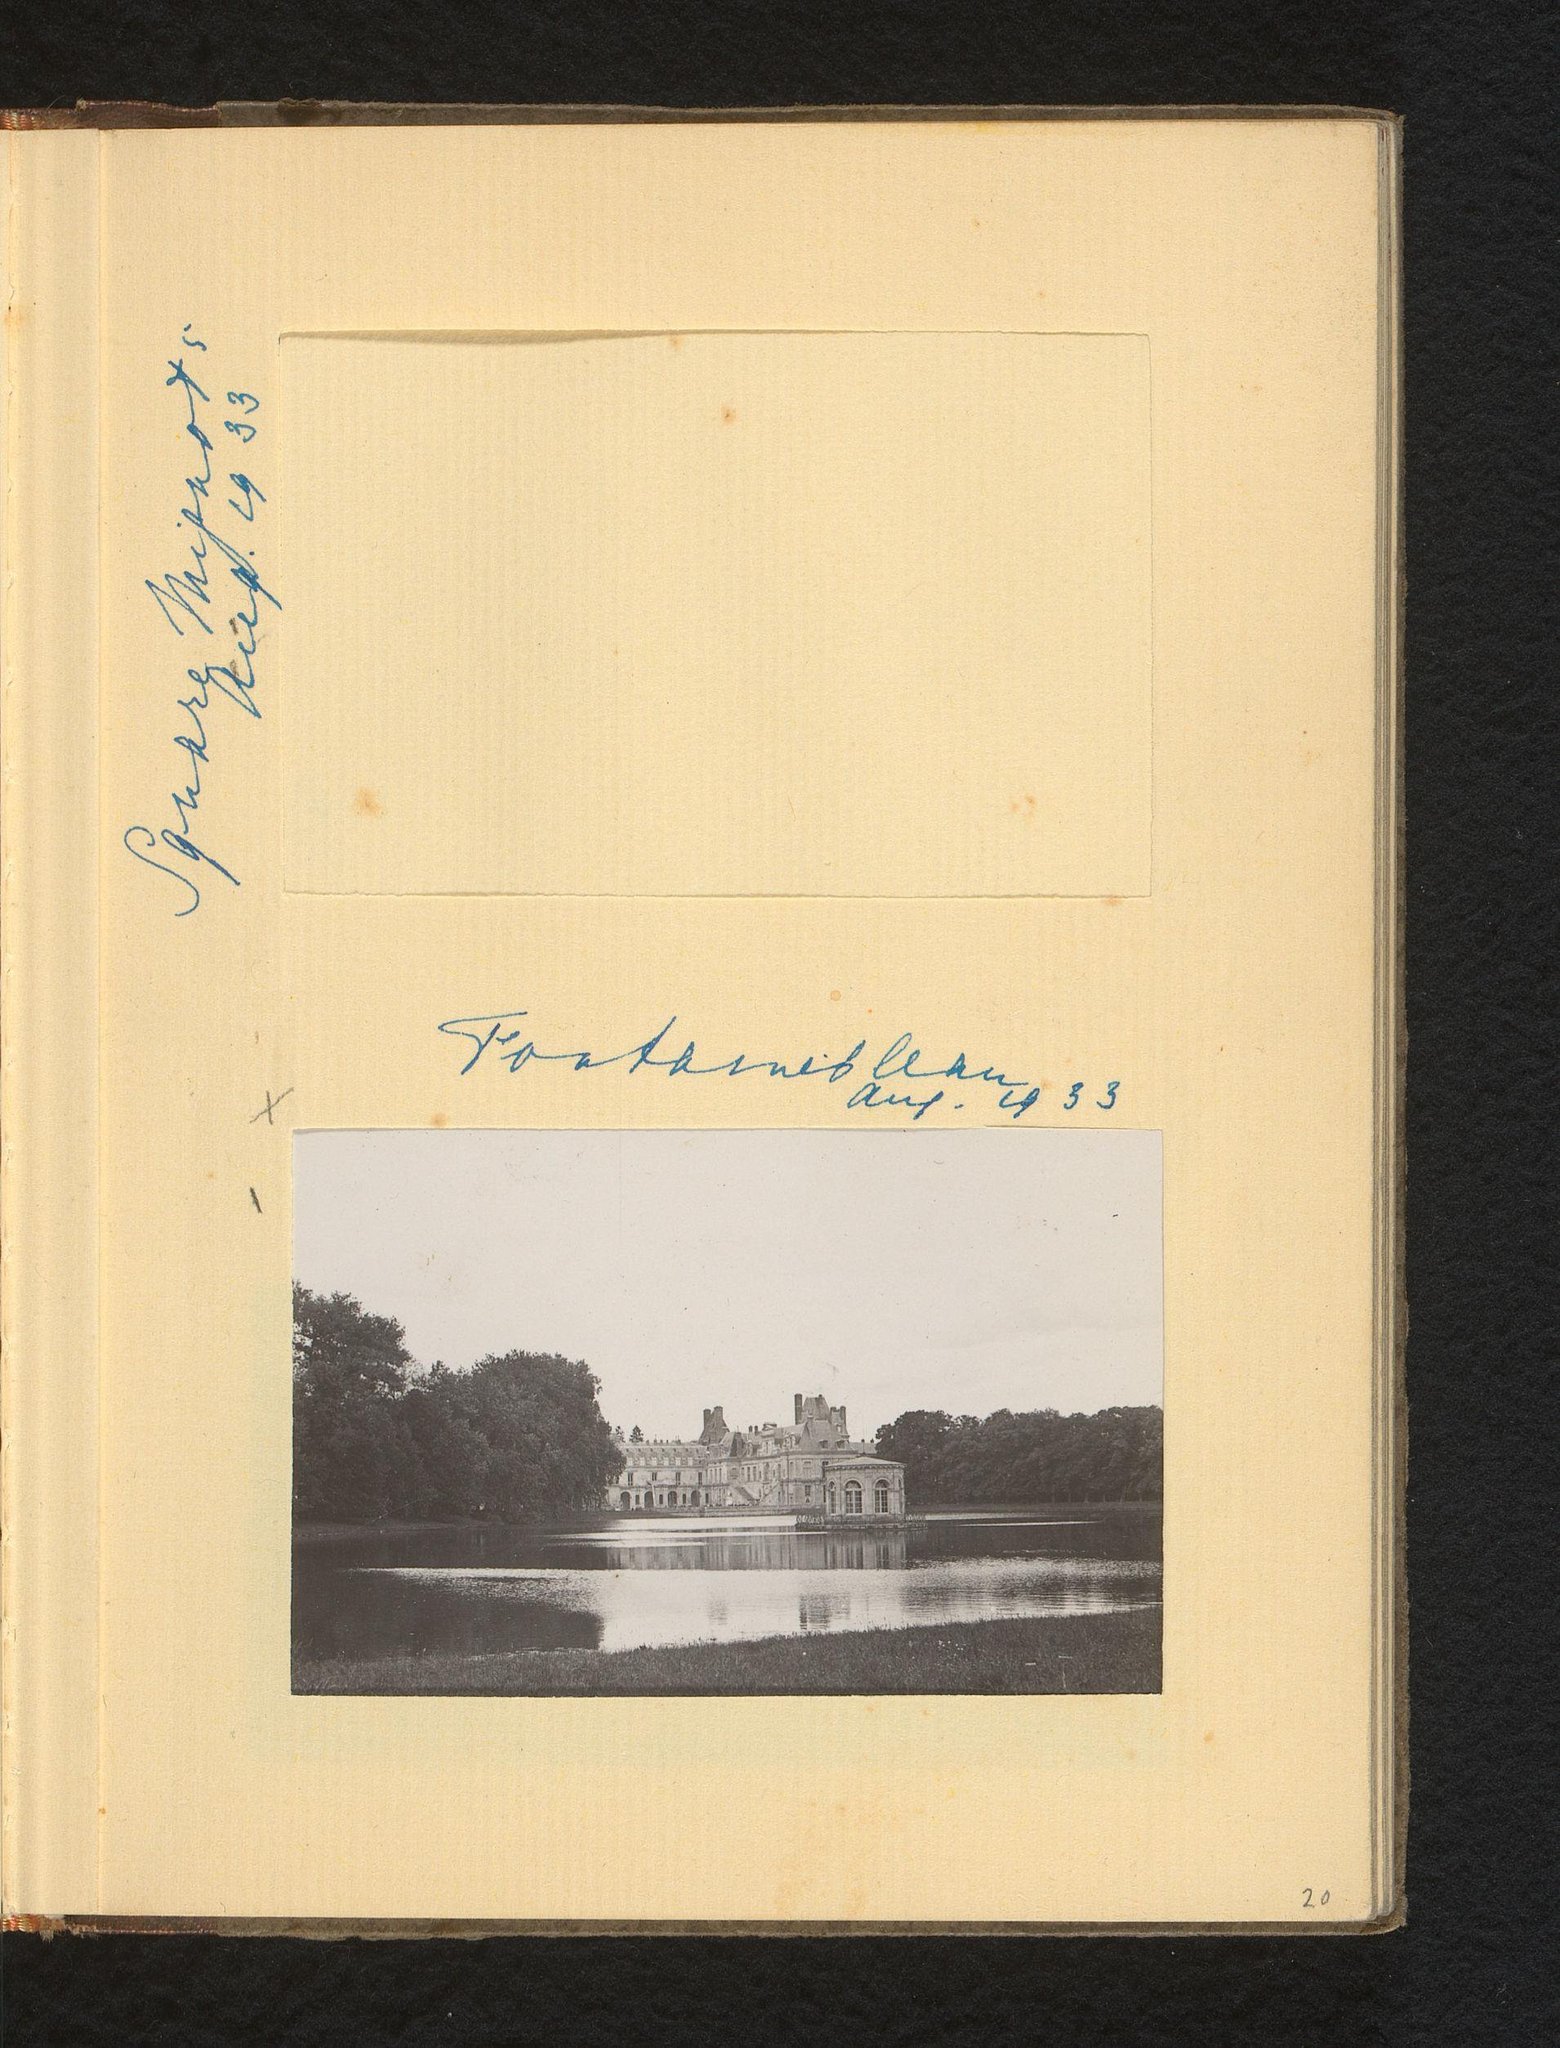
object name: album leaf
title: Gezicht op het kasteel van Fontainebleau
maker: Anonymous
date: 1908-1933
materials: paper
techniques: gelatin silver print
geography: fontainebleau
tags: castle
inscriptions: inscription: ‘Fontainebleau Aug. 1933’, inscription: ‘Square Mignots/ Aug. 1933’